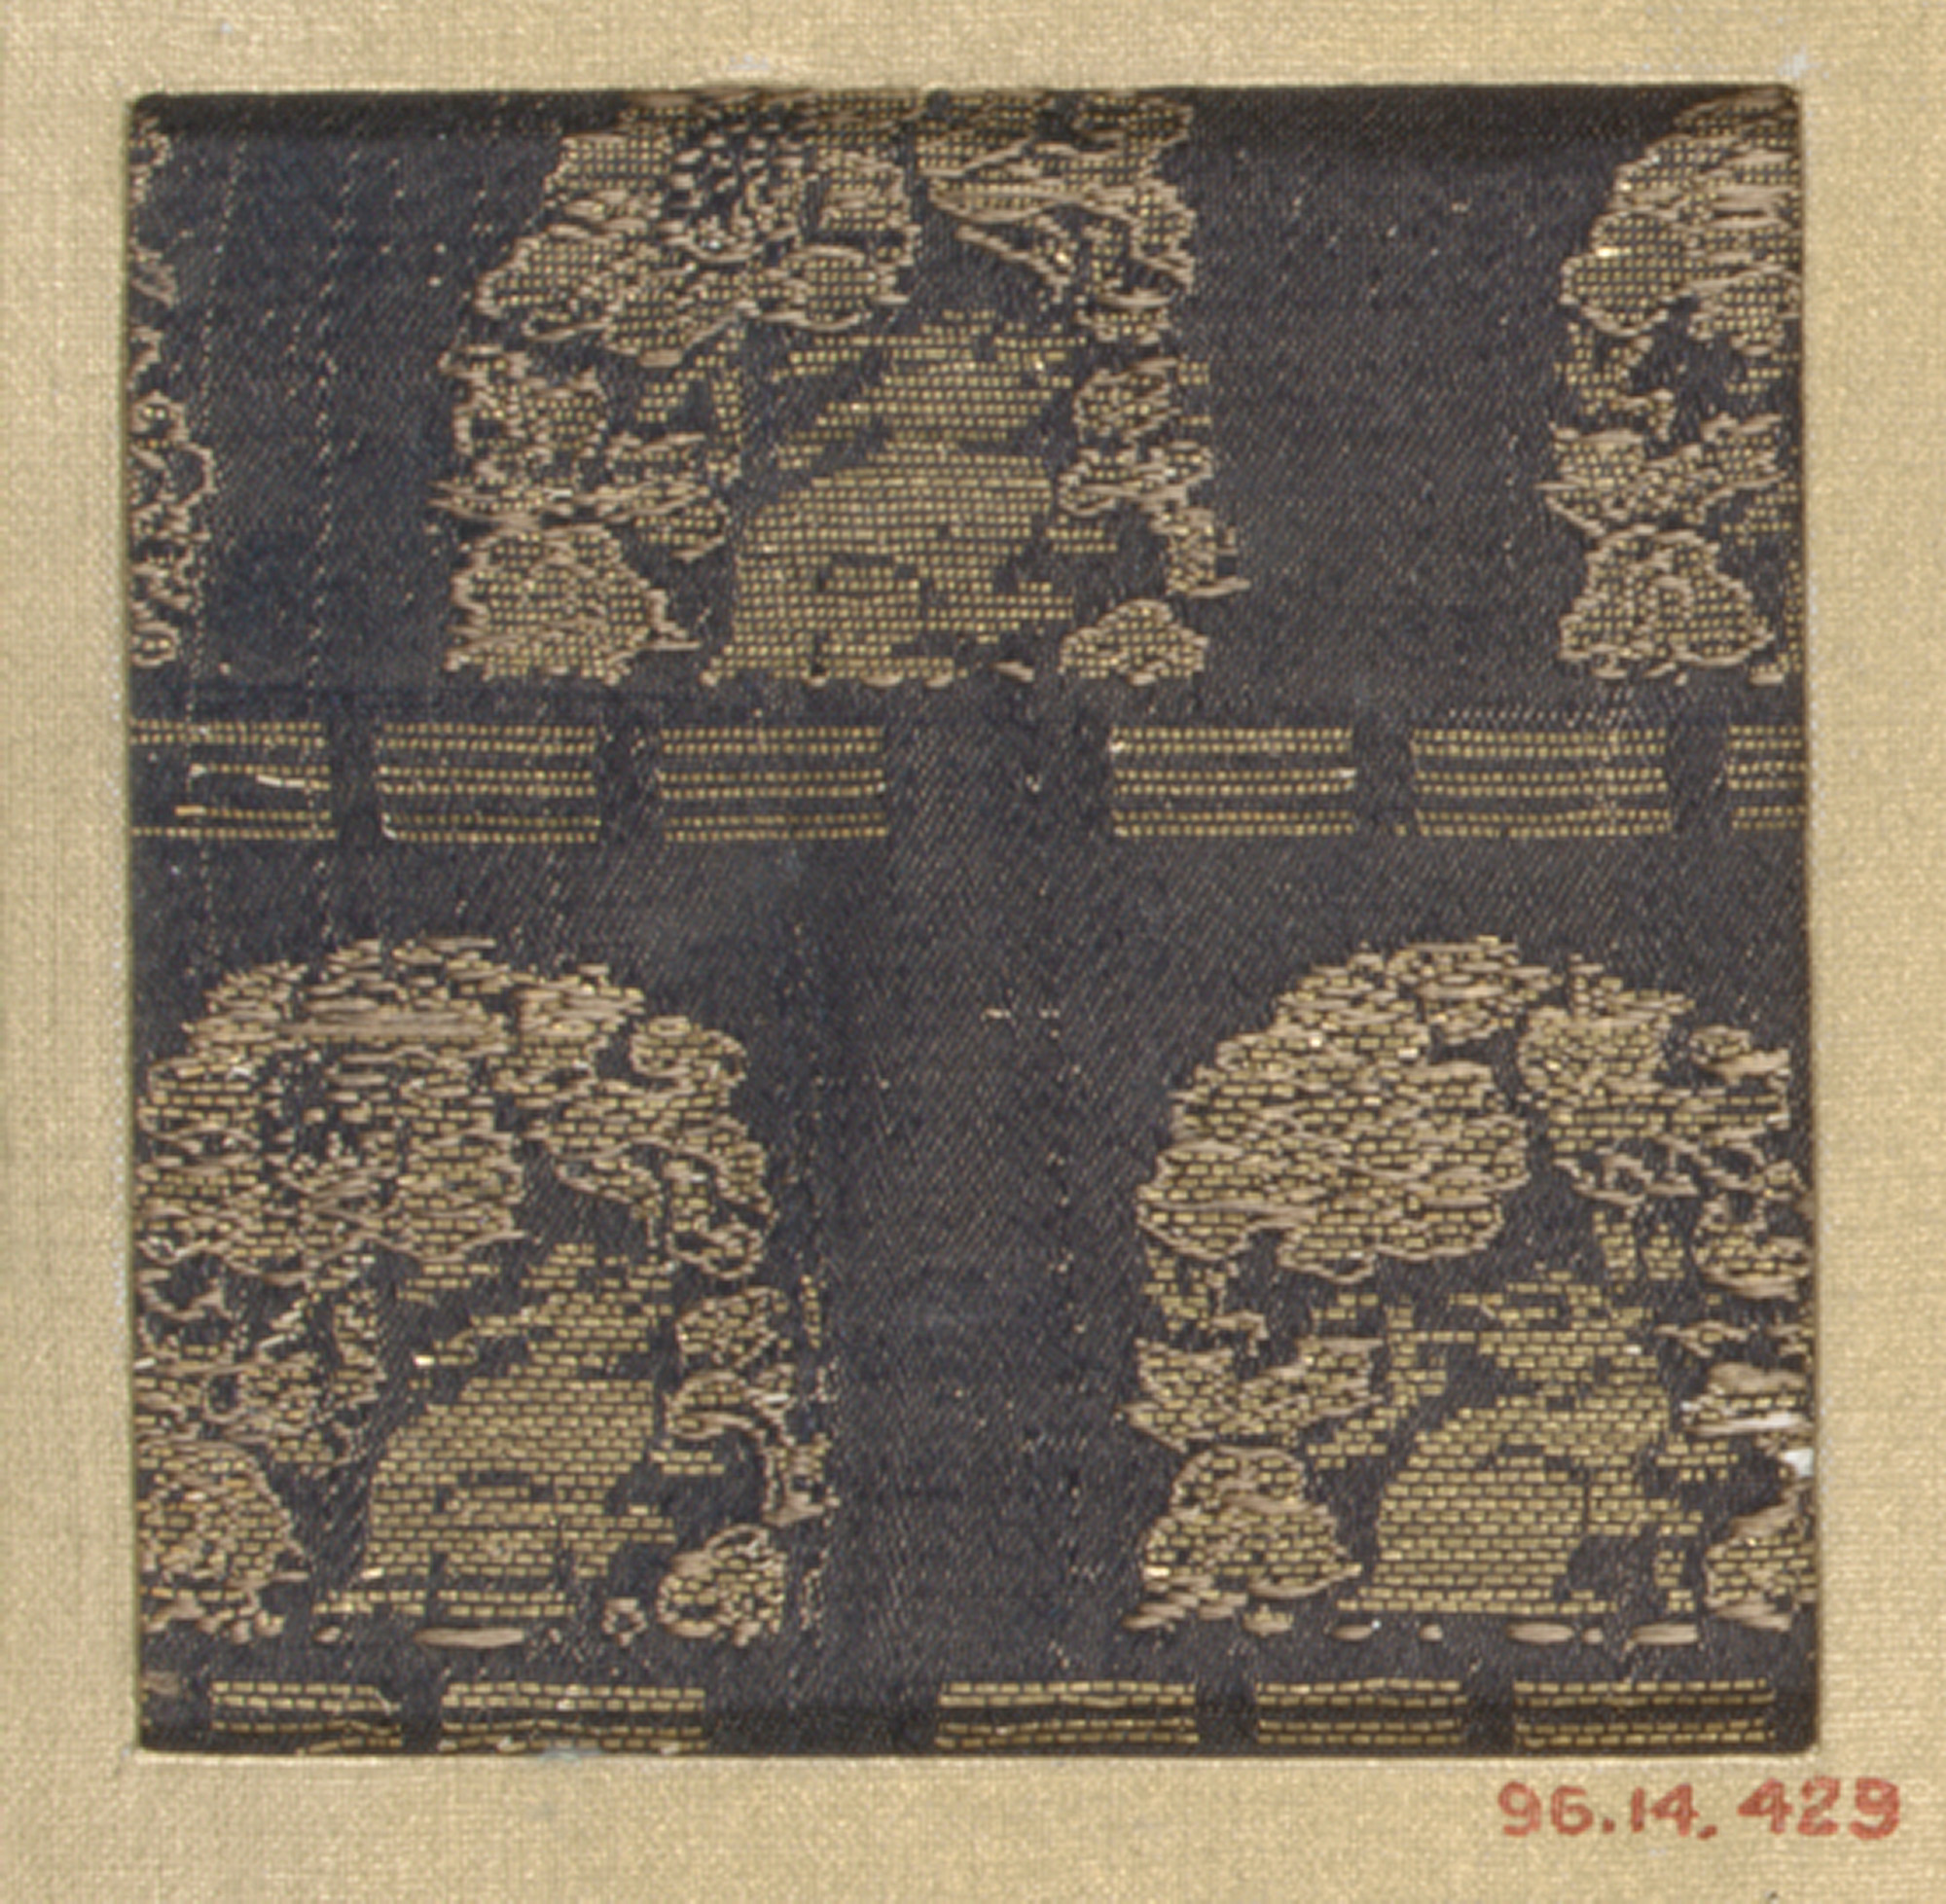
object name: piece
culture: japanese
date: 1801-1900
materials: metal thread, silk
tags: rabbits